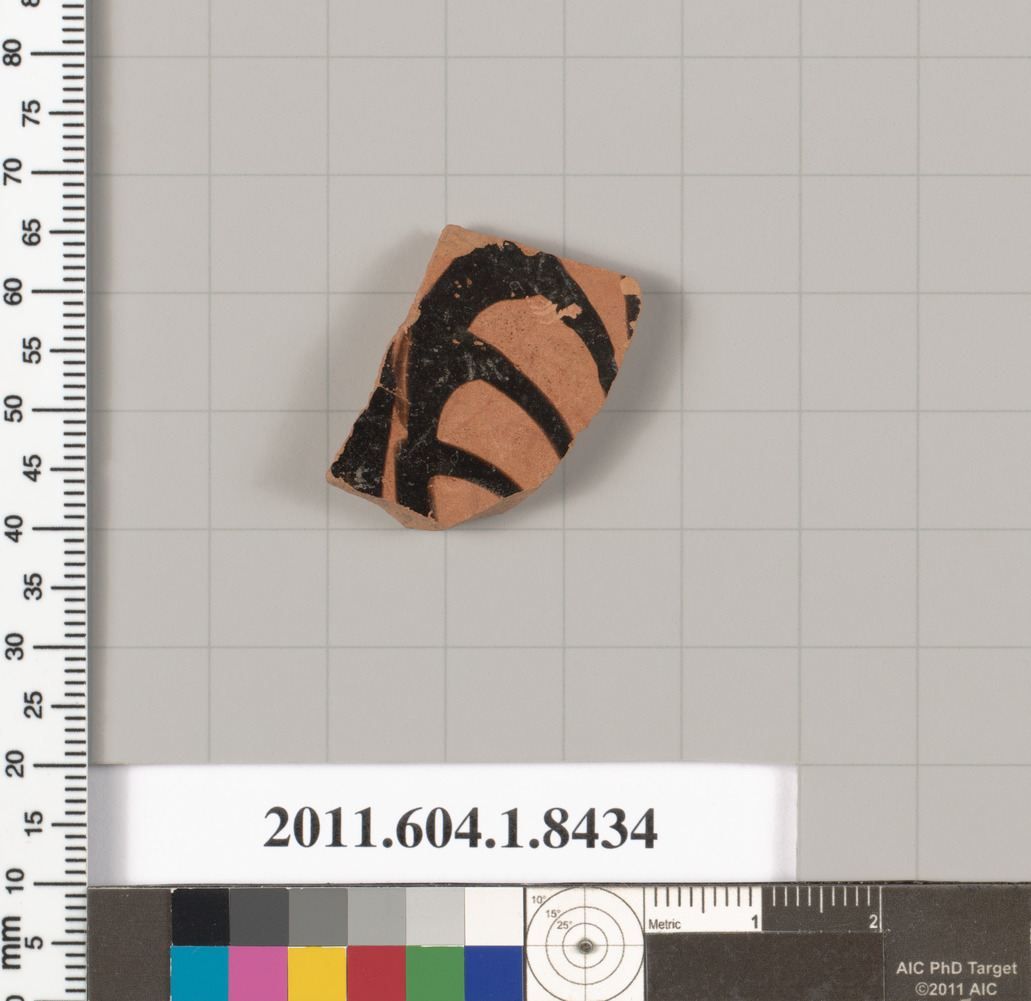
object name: kylix fragment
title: Terracotta fragment of a kylix (drinking cup)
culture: greek, attic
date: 400-351 BCE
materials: terracotta